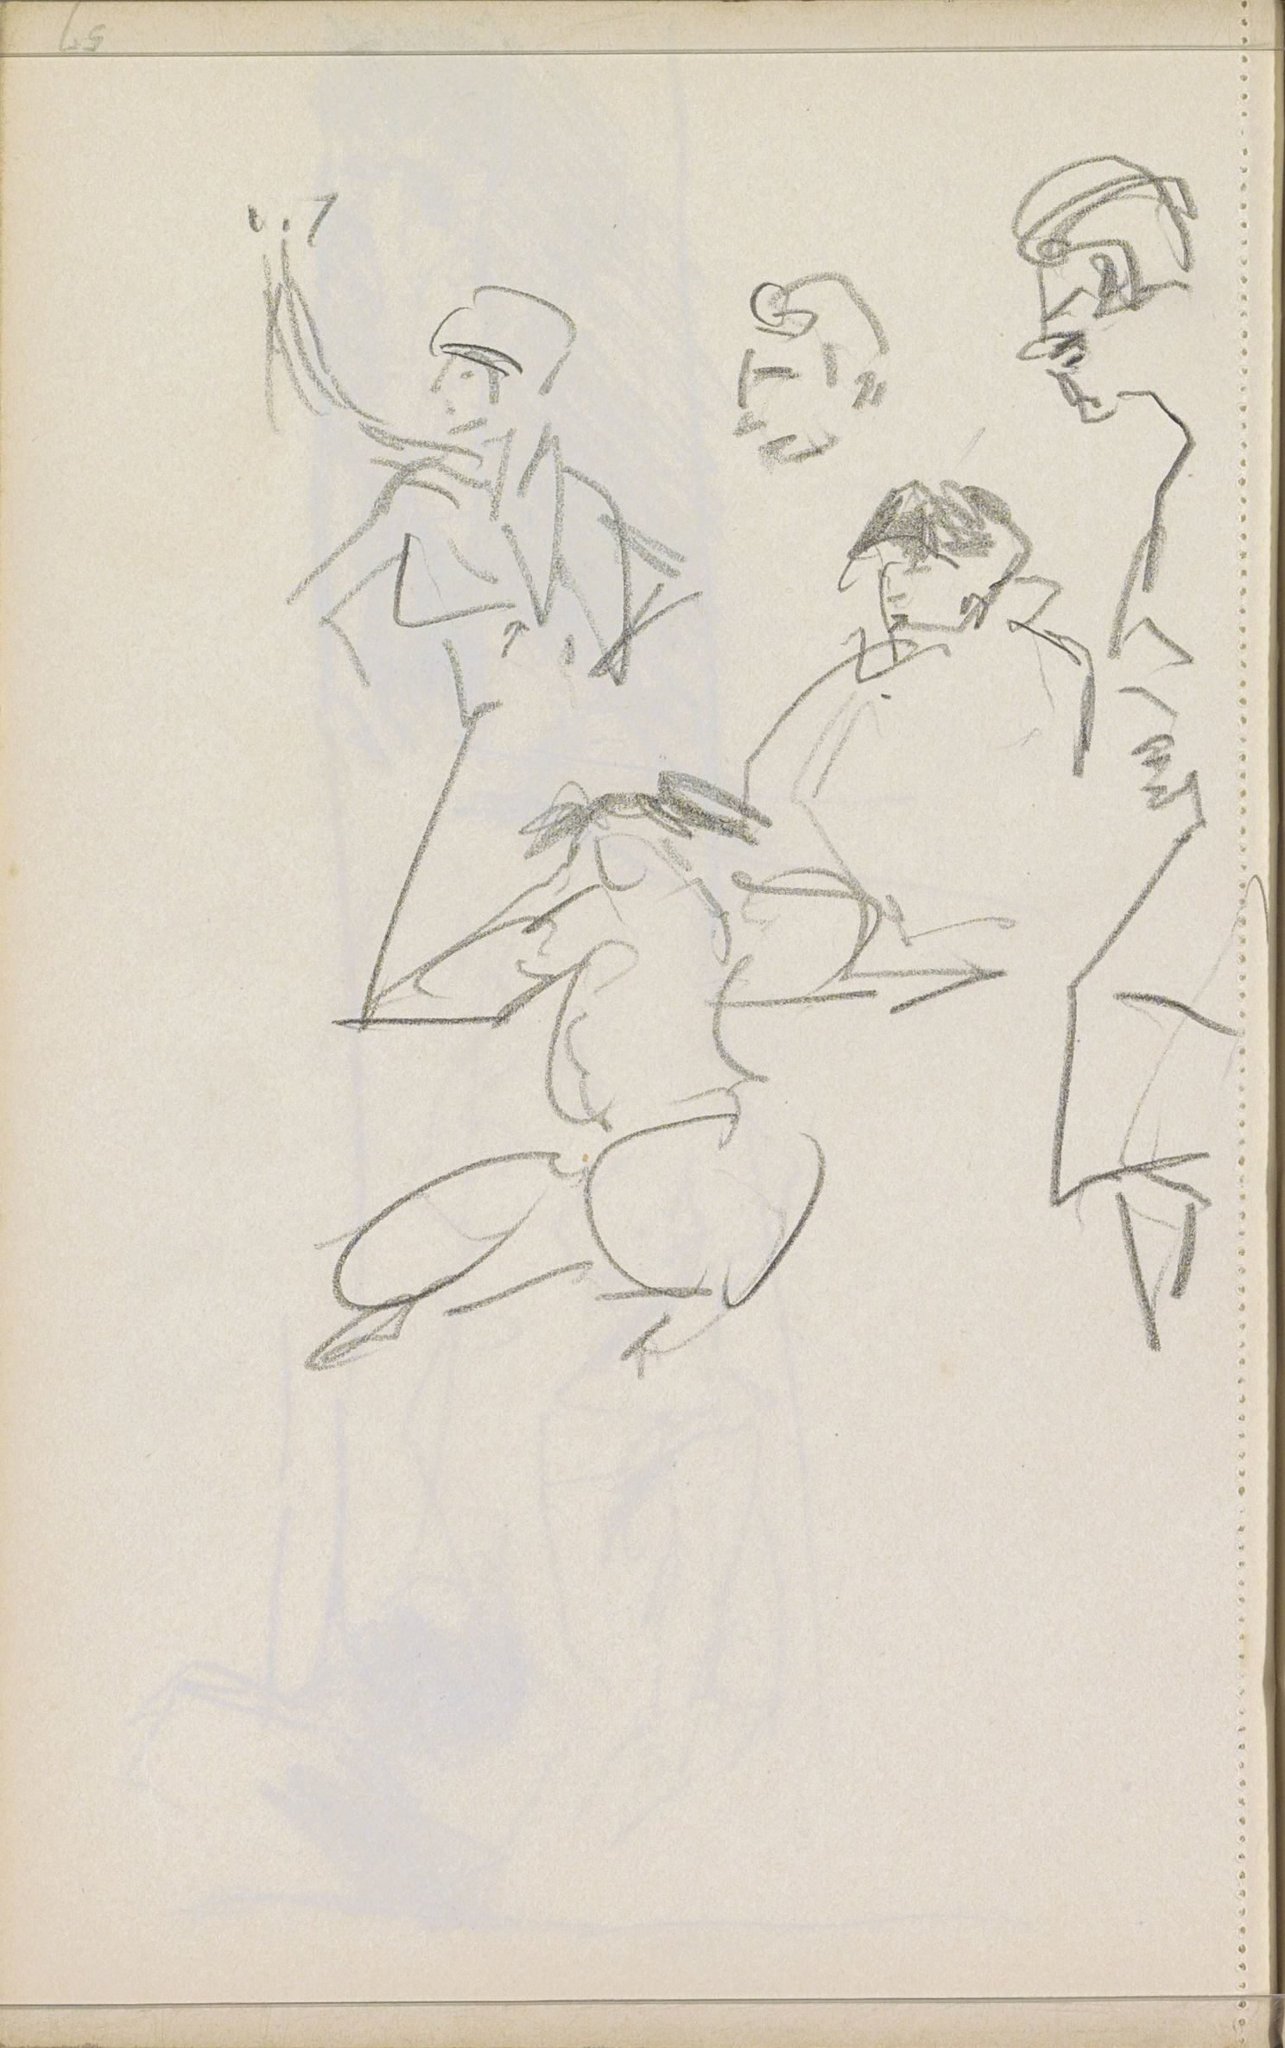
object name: sketchbook leaf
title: Figuurstudies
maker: isaac israels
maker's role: draughtsman, painter, print maker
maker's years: 1865-1934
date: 1875-1934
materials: paper, pencil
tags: the (nude) human figure; 'corpo humano' (ripa), the (nude) human figure; 'corpo humano' (ripa) - aa - female human figure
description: Blad 30 verso uit schetsboek LII met 43 bladen.